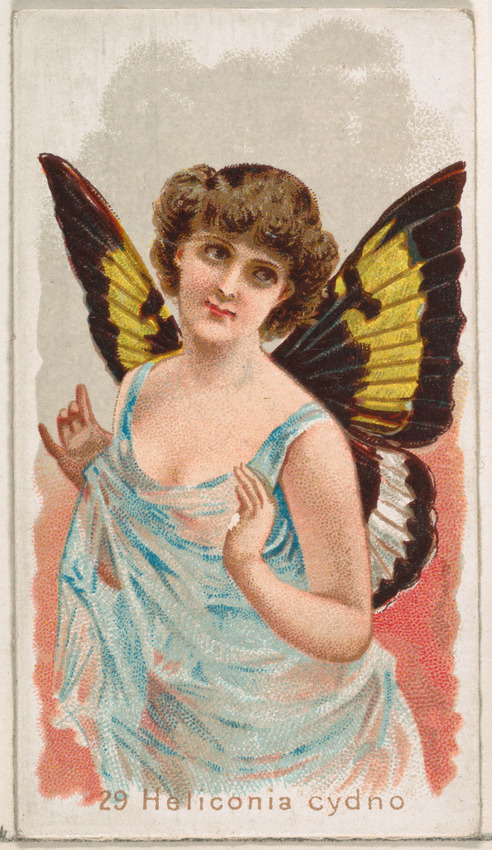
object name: print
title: Card 29, Heliconia Cydno, from the Butterflies series (N183) issued by Wm. S. Kimball & Co.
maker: william s. kimball & company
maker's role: publisher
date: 1888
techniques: color lithograph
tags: women,butterflies